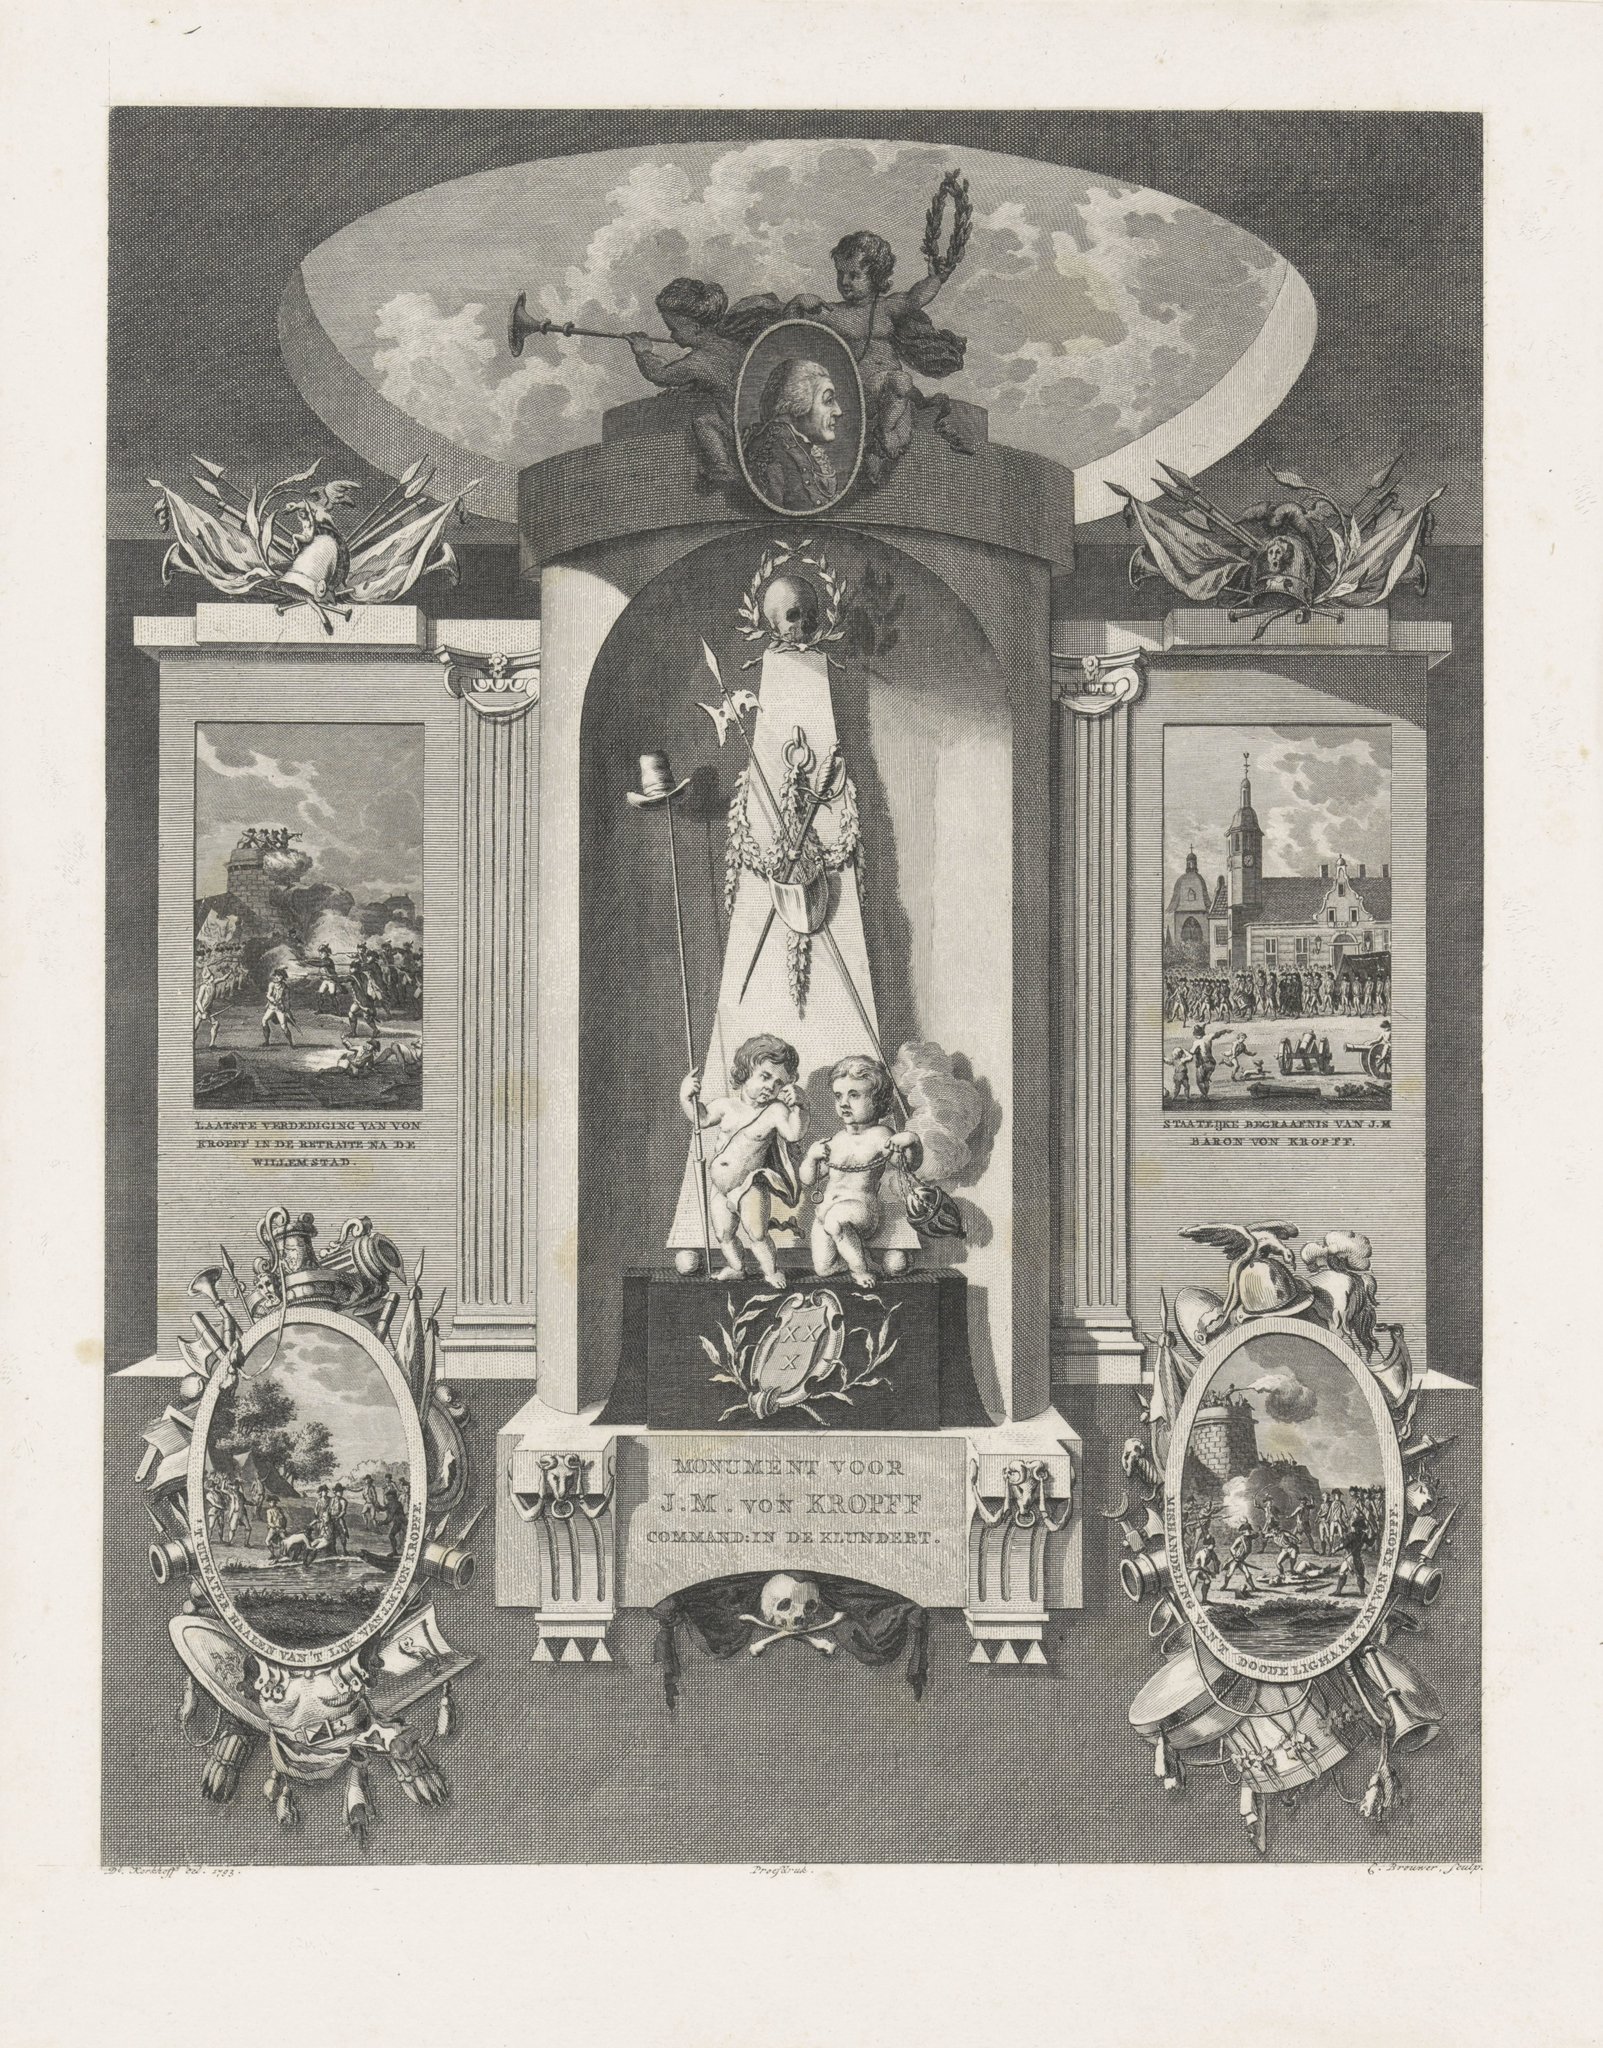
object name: print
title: Monument voor J.M. von Kropff command: in de Klundert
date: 1793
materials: paper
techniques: engraving, etching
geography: northern netherlands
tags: klundert, cortege, funeral procession, mutilation of the corpse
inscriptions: collector's mark: Lugt 2228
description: Allegorisch monument voor Joachim Maurits baron van Kropff, gesneuveld bij de verdediging van Klundert tegen het Franse leger, 25 februari 1793. Boven de zuil een medaillon met portret. Aan weerszijden van de zuil vier voorstellingen van de laatste verdediging van de vesting, de mishandeling van het lichaam van Kropff door de Fransen, het uit het water halen van zijn lichaam en zijn begrafenis in Willemstad.